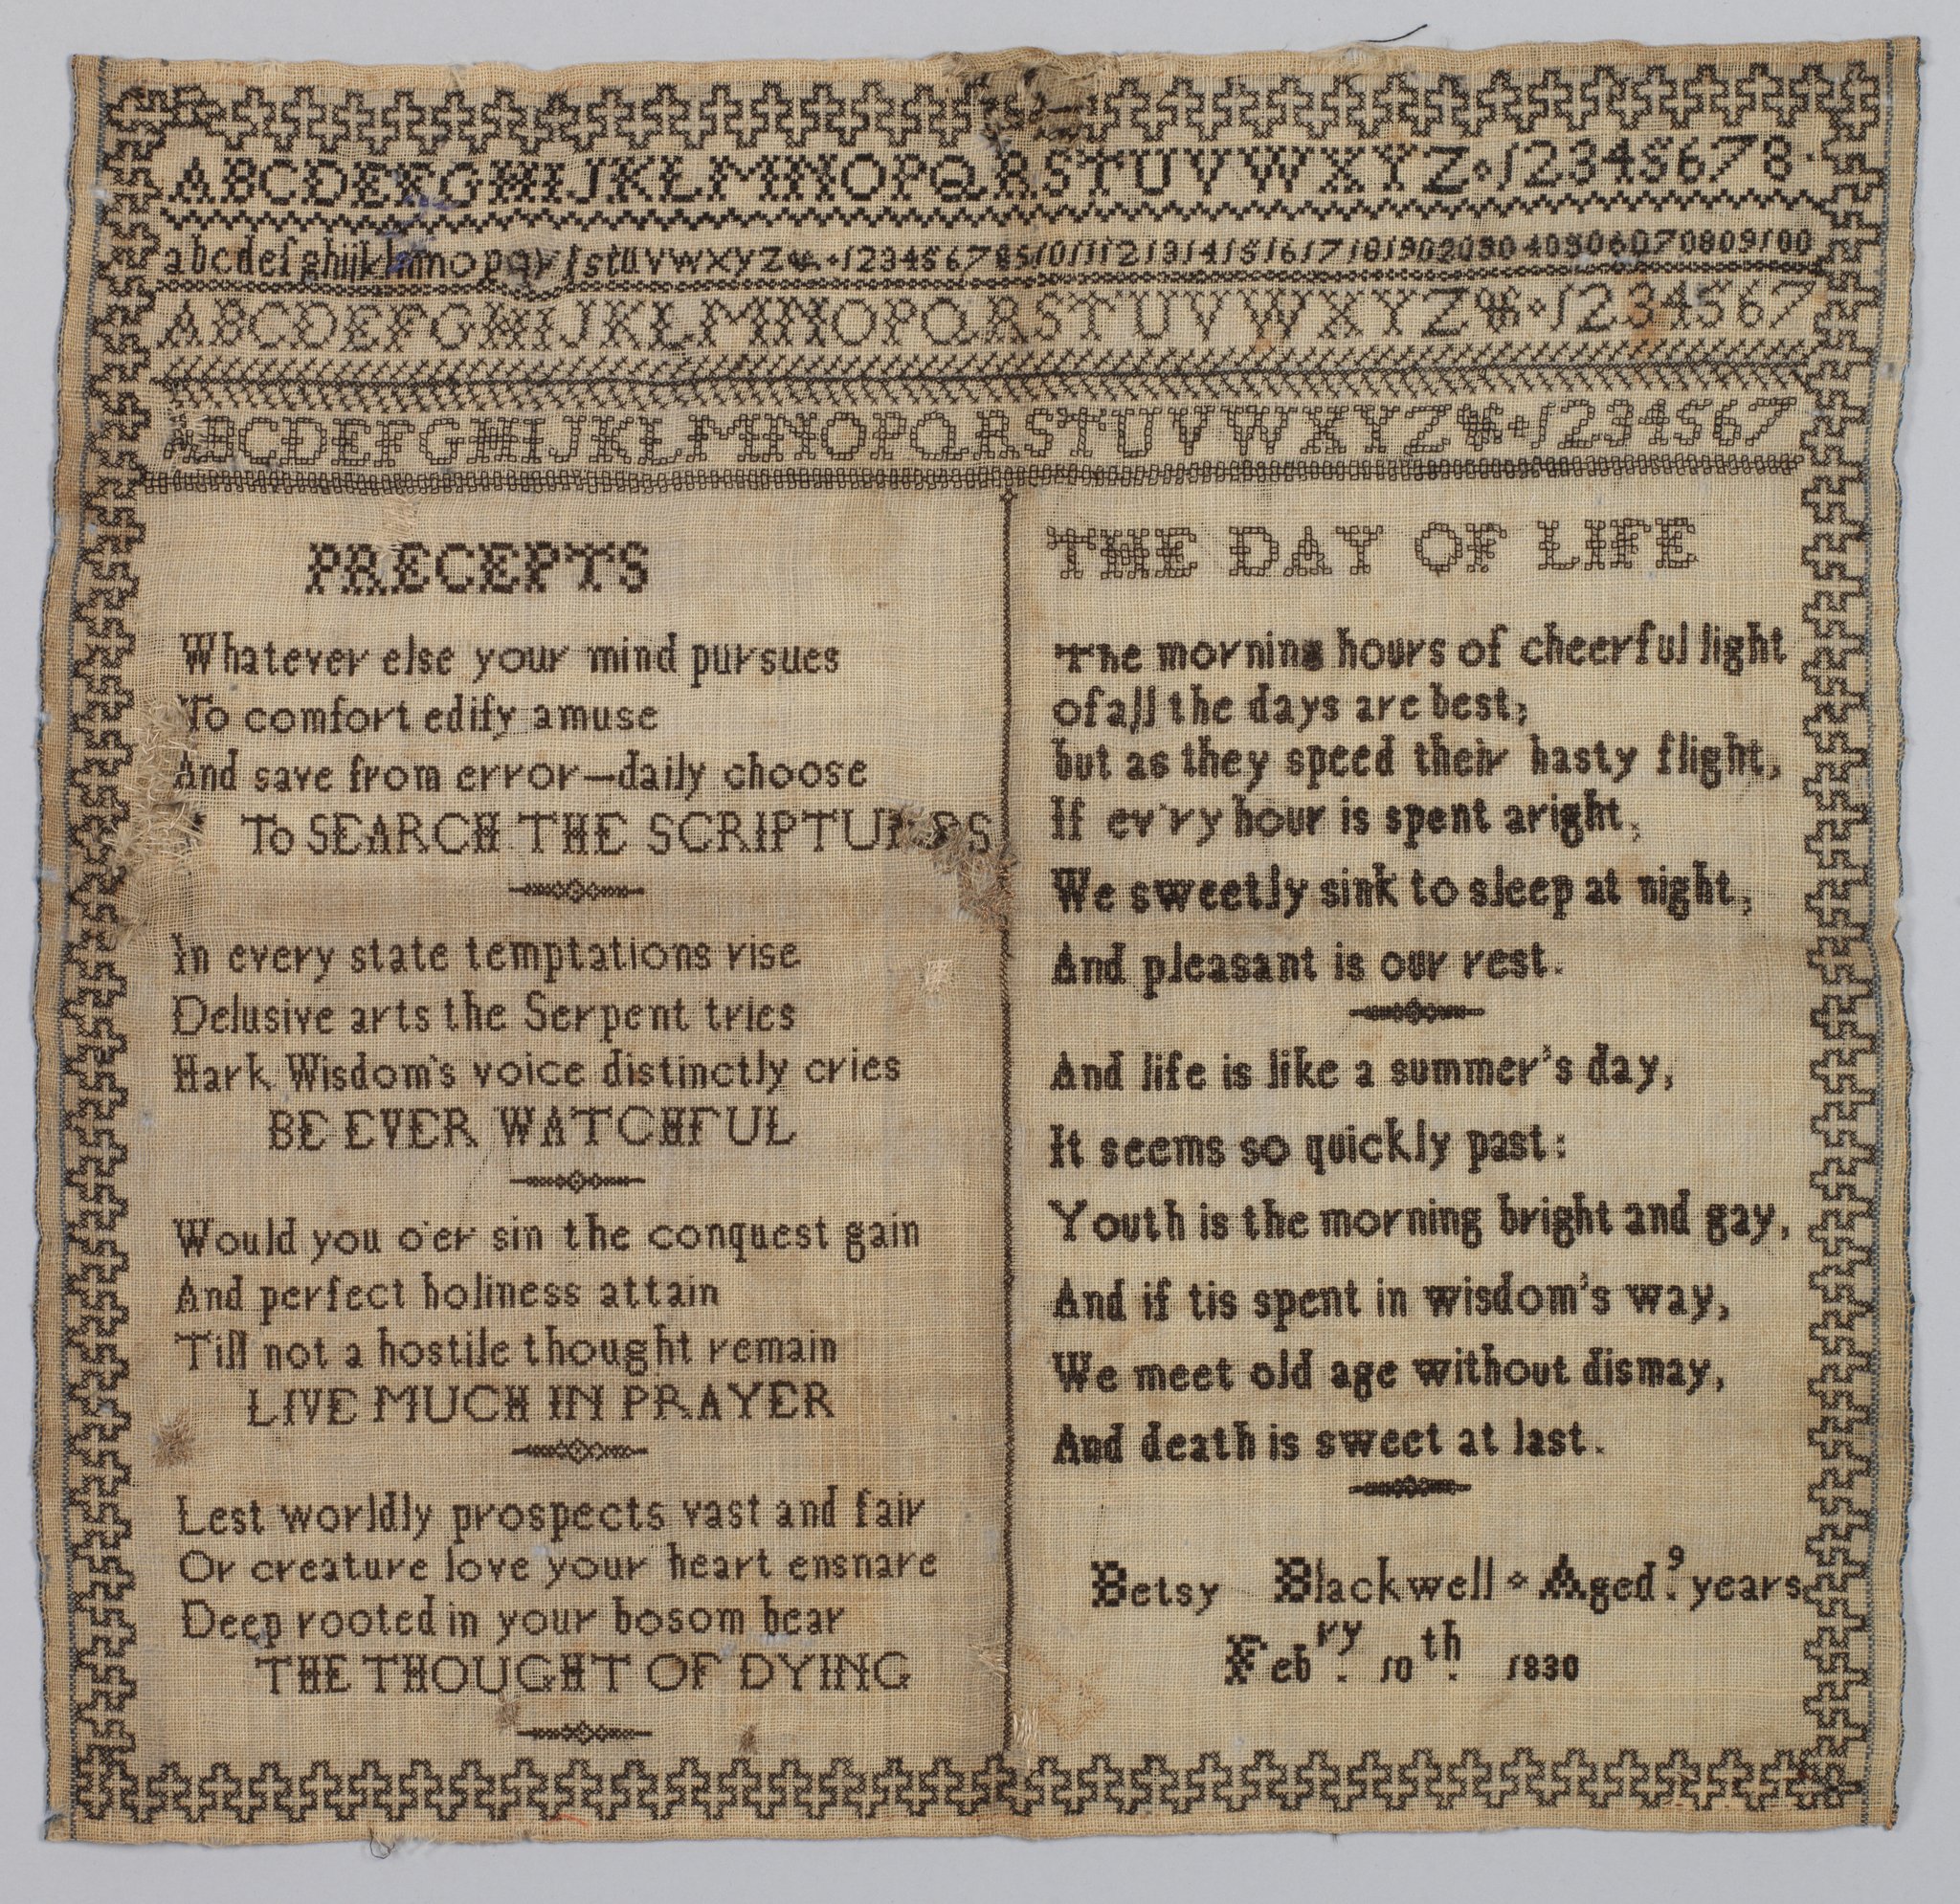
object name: sampler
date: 1830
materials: canvas, silk, wool